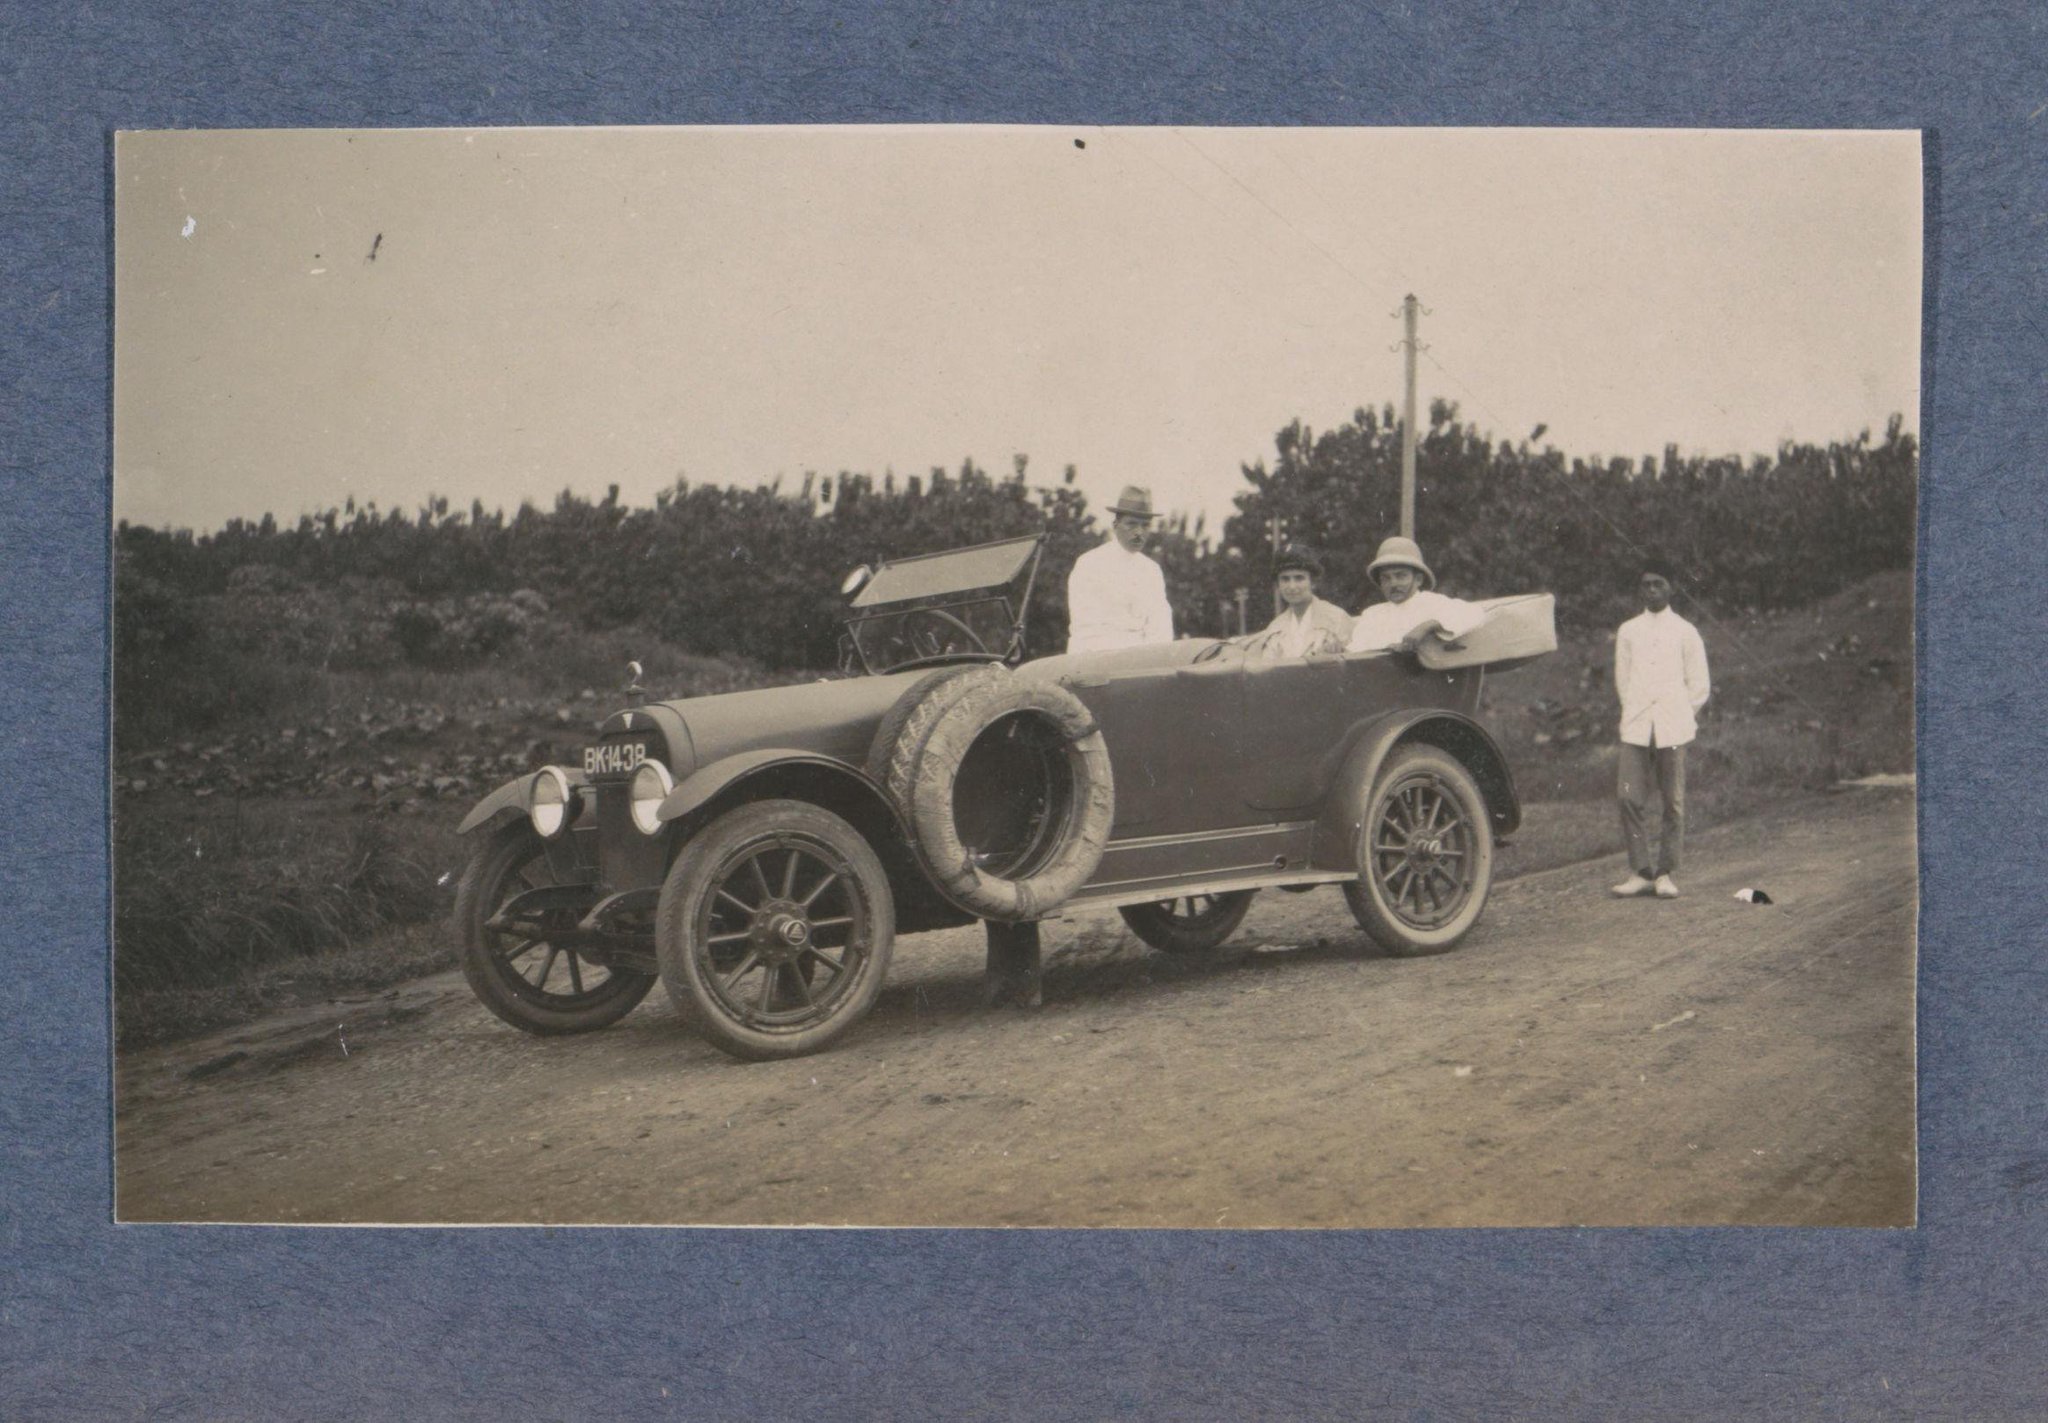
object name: album leaf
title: op Two Rivers met John en C. Kroese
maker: Anonymous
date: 1900-1920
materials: paper, photographic support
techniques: gelatin silver print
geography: sumatra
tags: plantation, automobile, sumatra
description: Onderdeel van reisalbum met foto's van bedrijvigheid en bezienswaardigheden op Sumatra en Java en van de reis naar en van Nederlands-Indië.